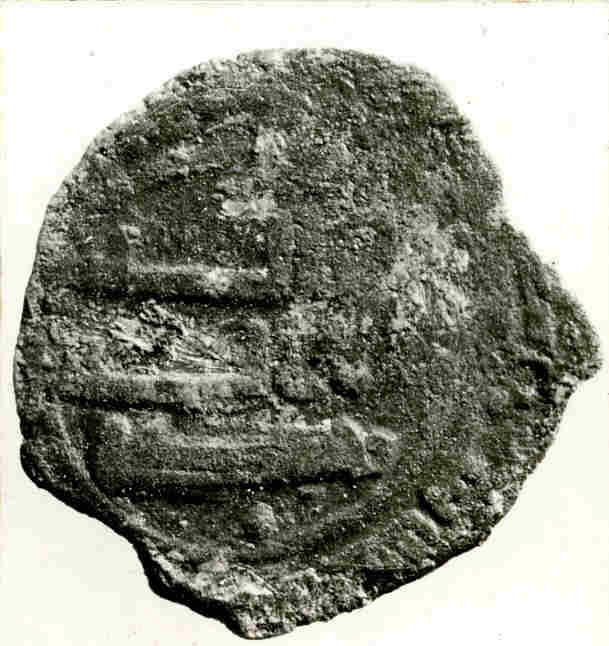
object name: coin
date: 701-900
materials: copper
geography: iran